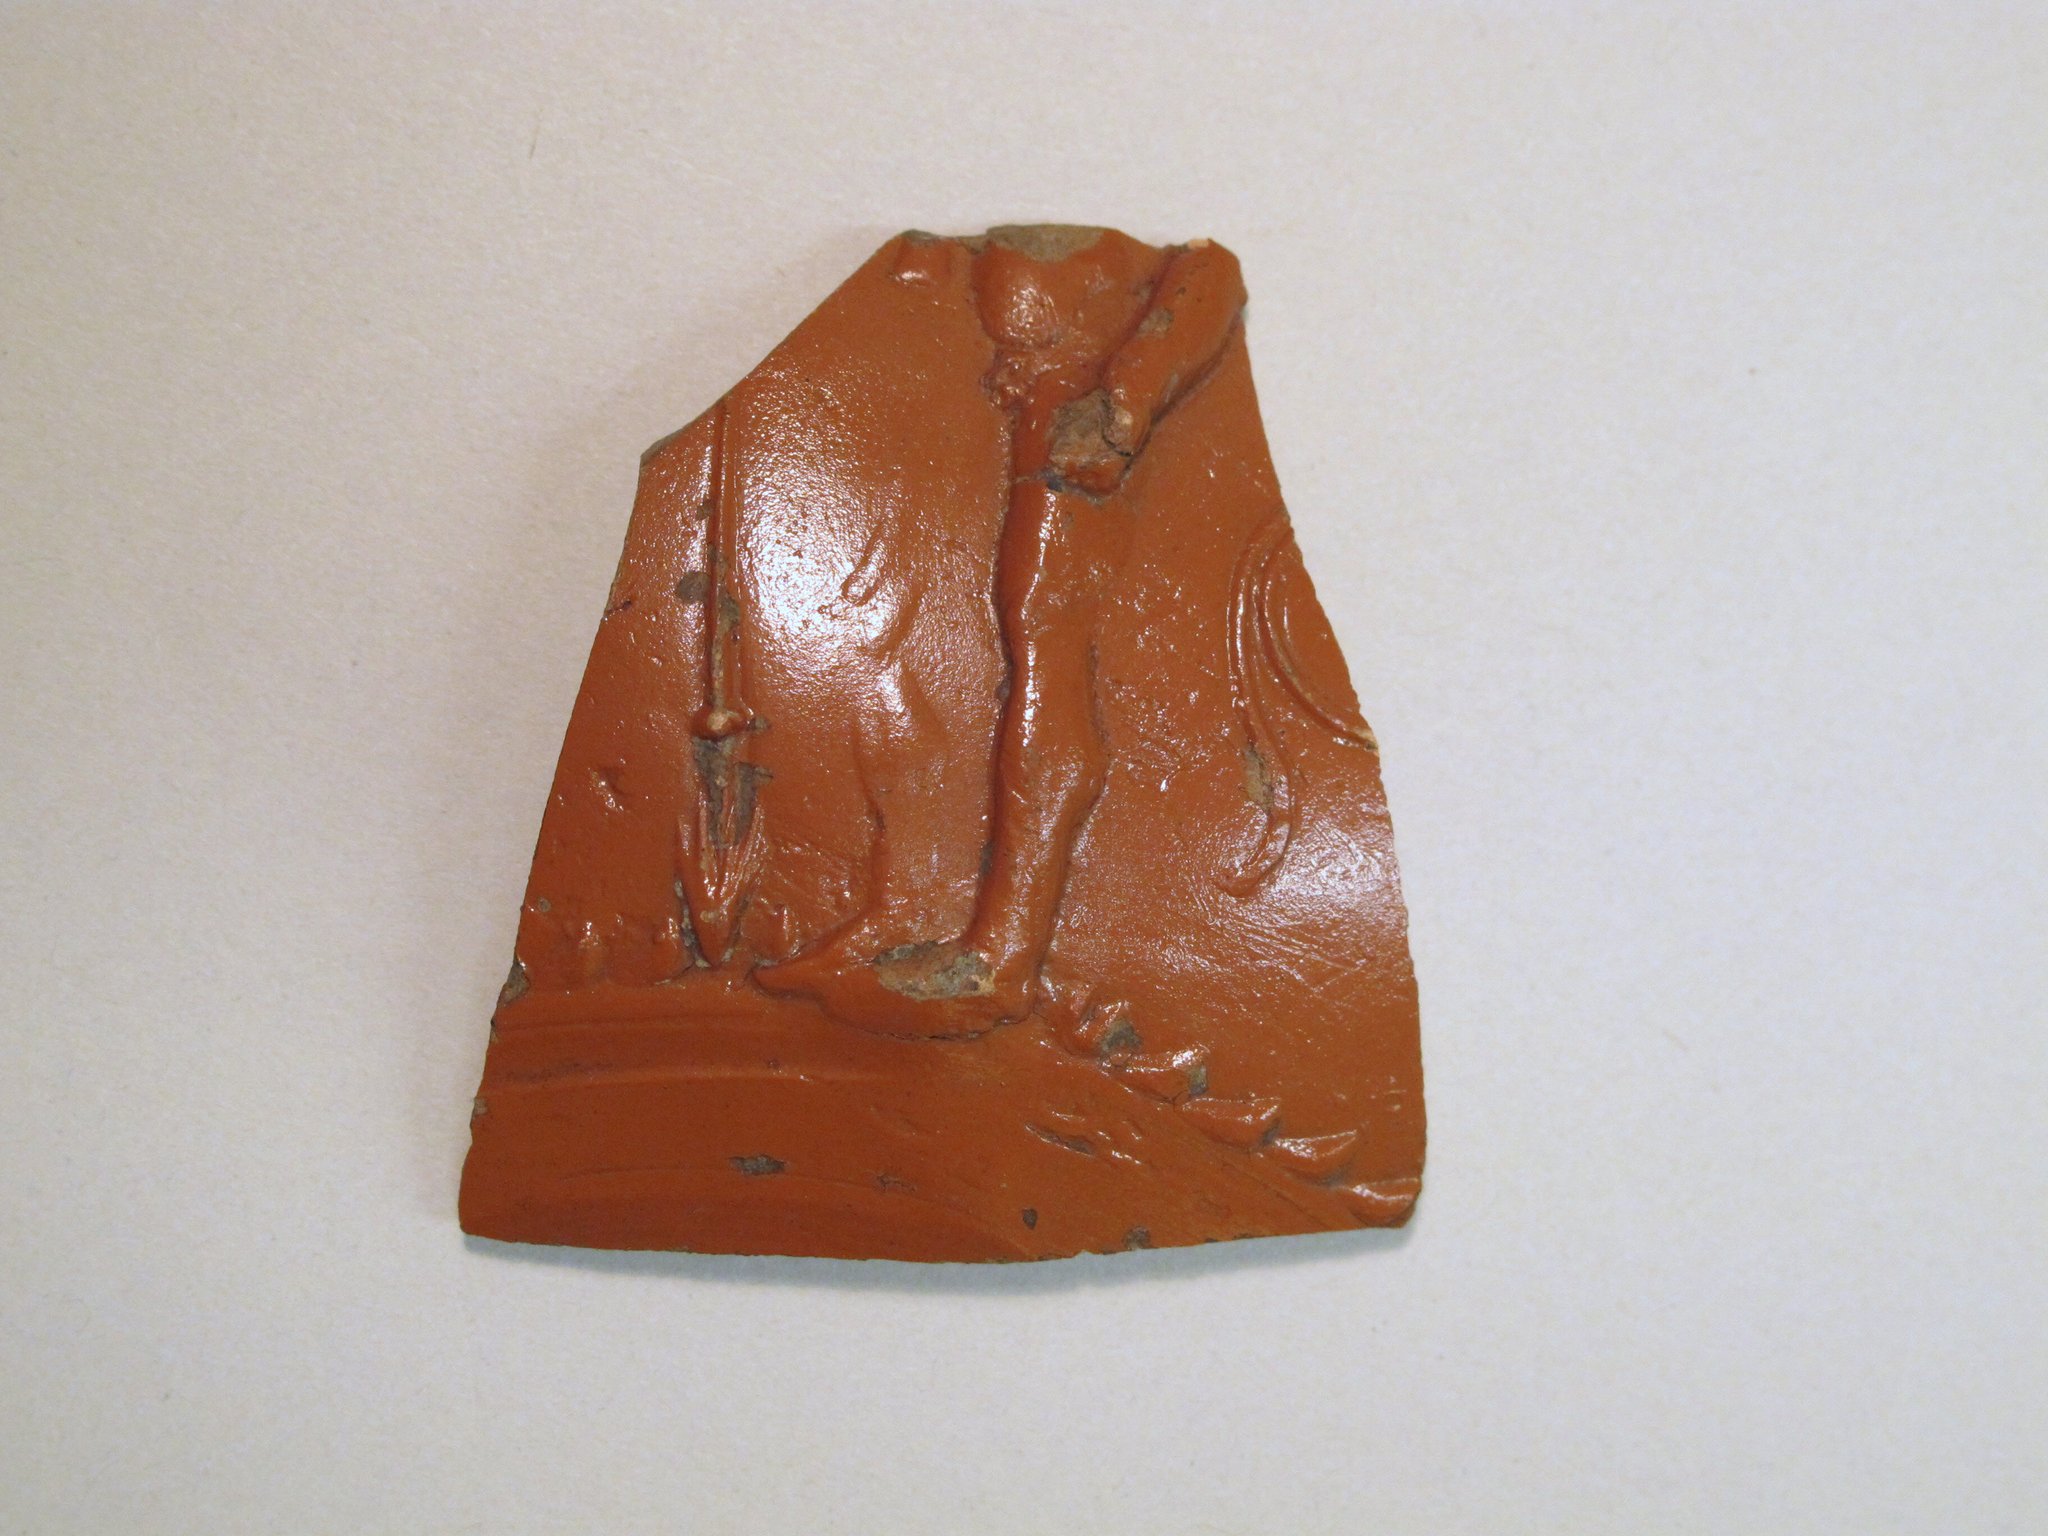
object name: vase fragment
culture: roman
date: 100 BCE-100 CE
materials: terracotta